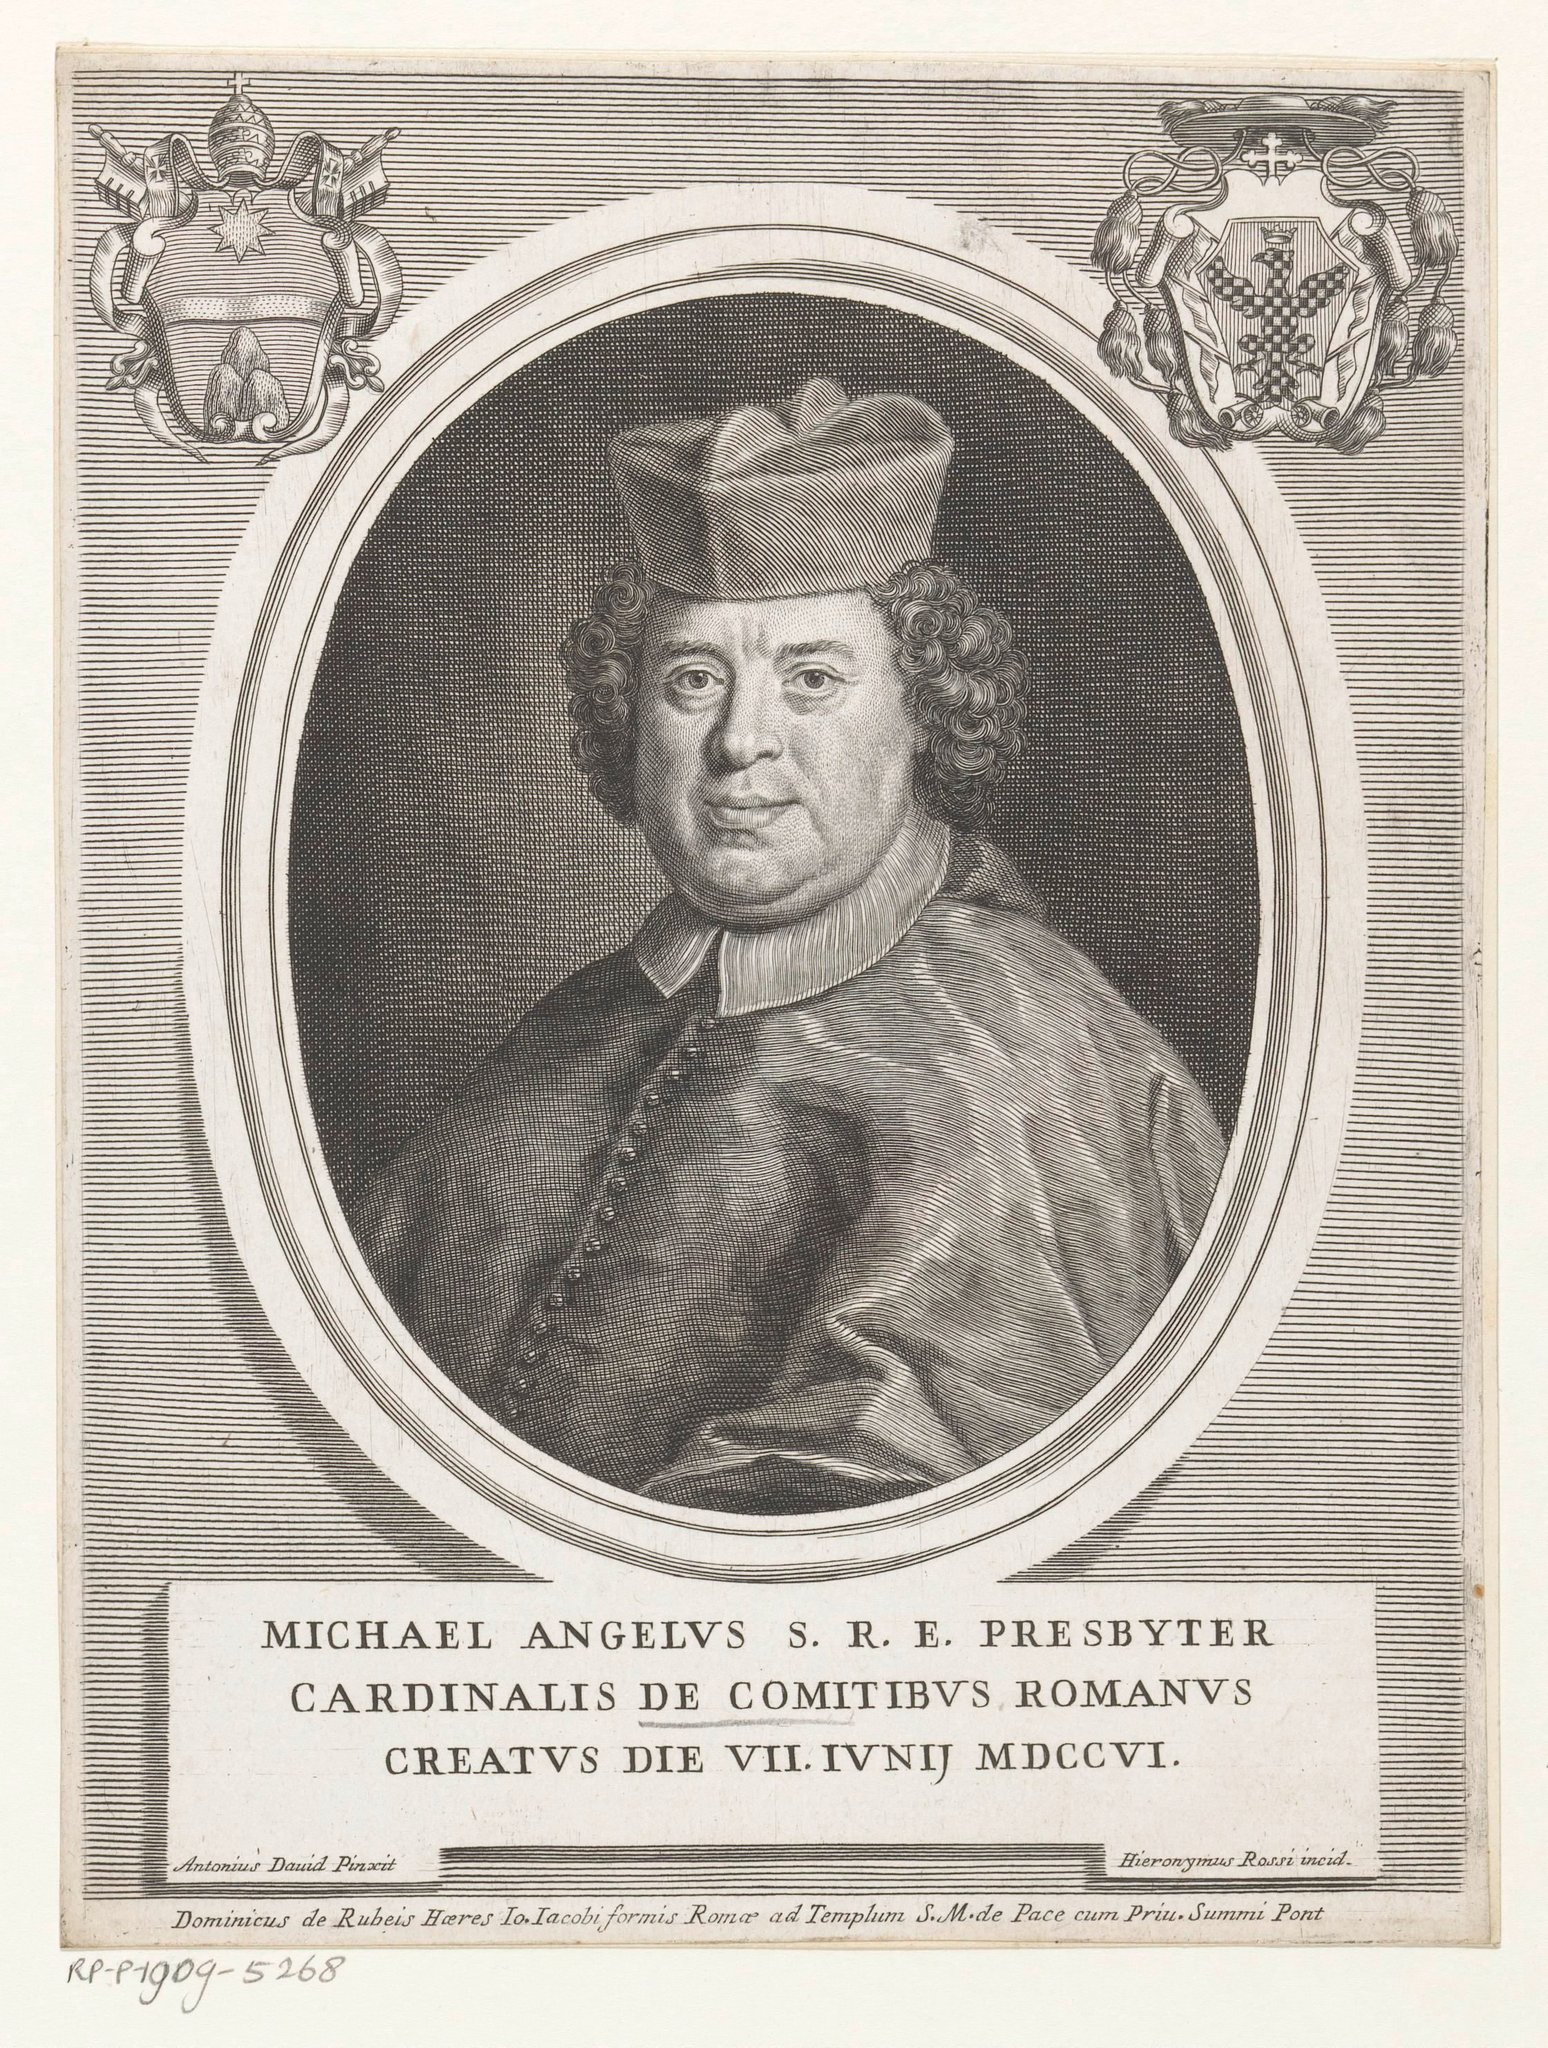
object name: print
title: Portret van kardinaal Michelangelo Conti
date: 1706-1762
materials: paper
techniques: engraving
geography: vatican city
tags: italy, rome, cardinal, historical persons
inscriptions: collector's mark: Lugt 2228